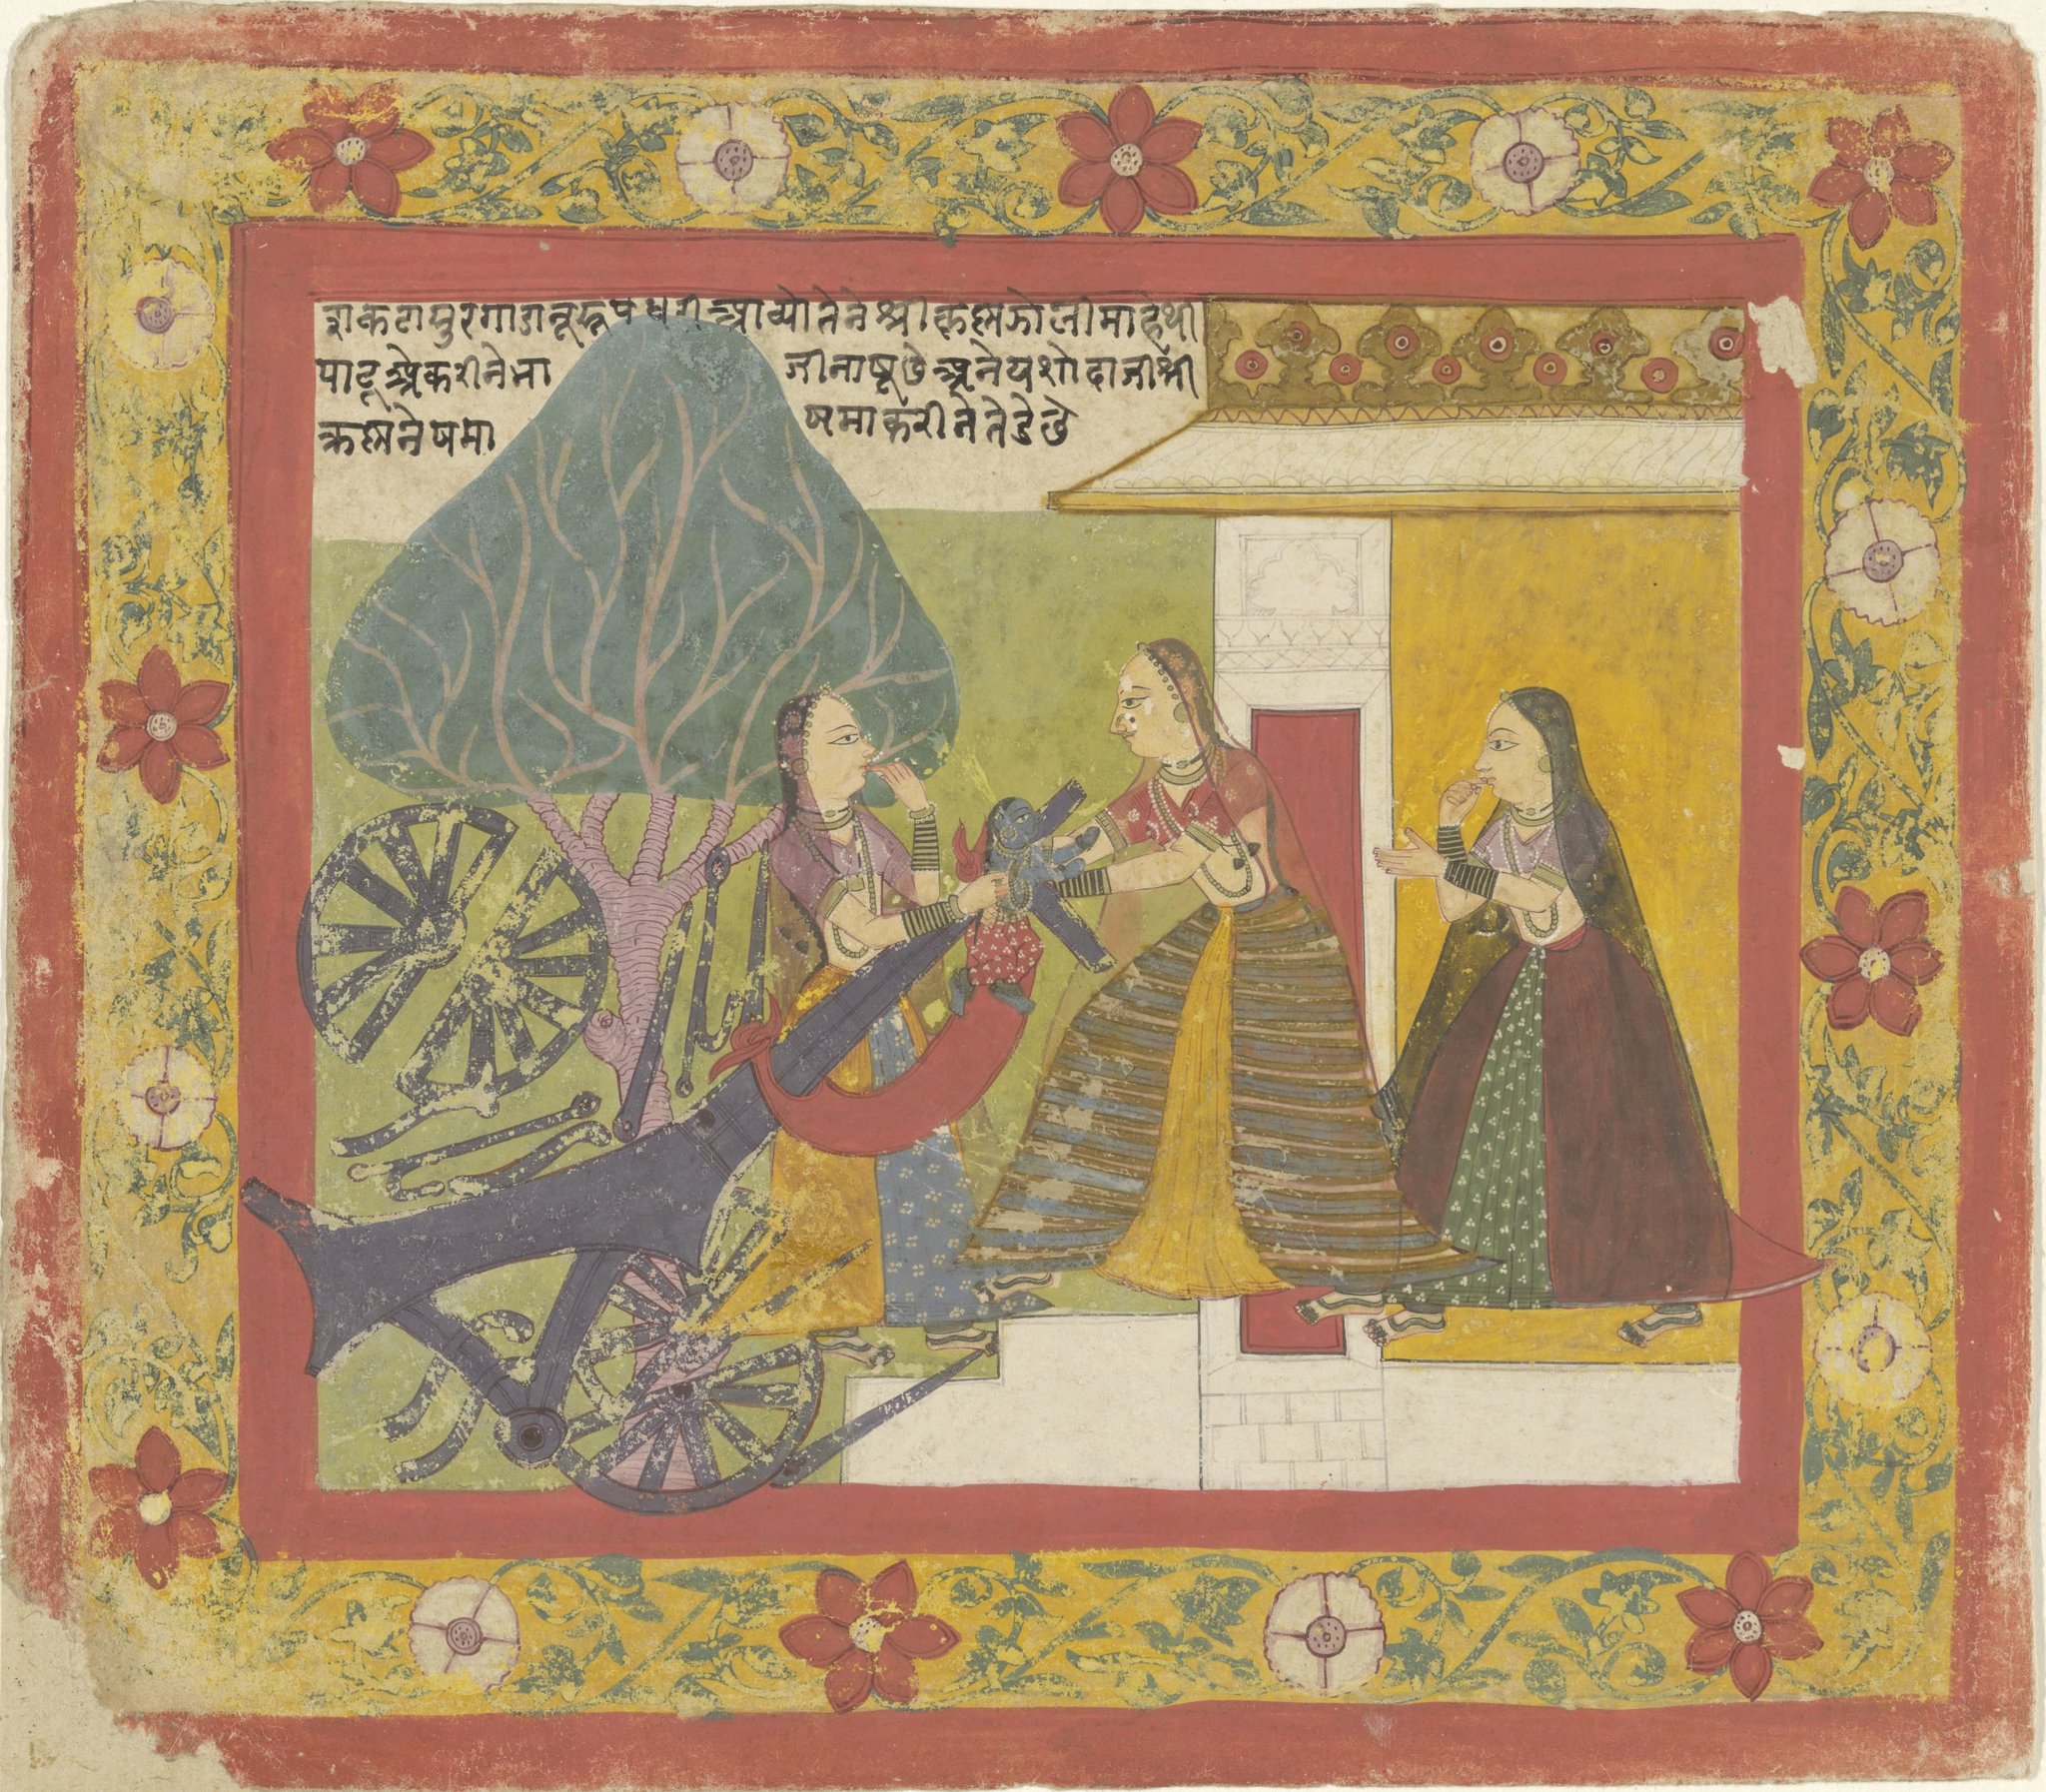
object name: indian miniature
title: Krishna heeft de wagendemon vernietigd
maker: Anonymous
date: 1620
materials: paper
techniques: brush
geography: sirohi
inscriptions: inscription